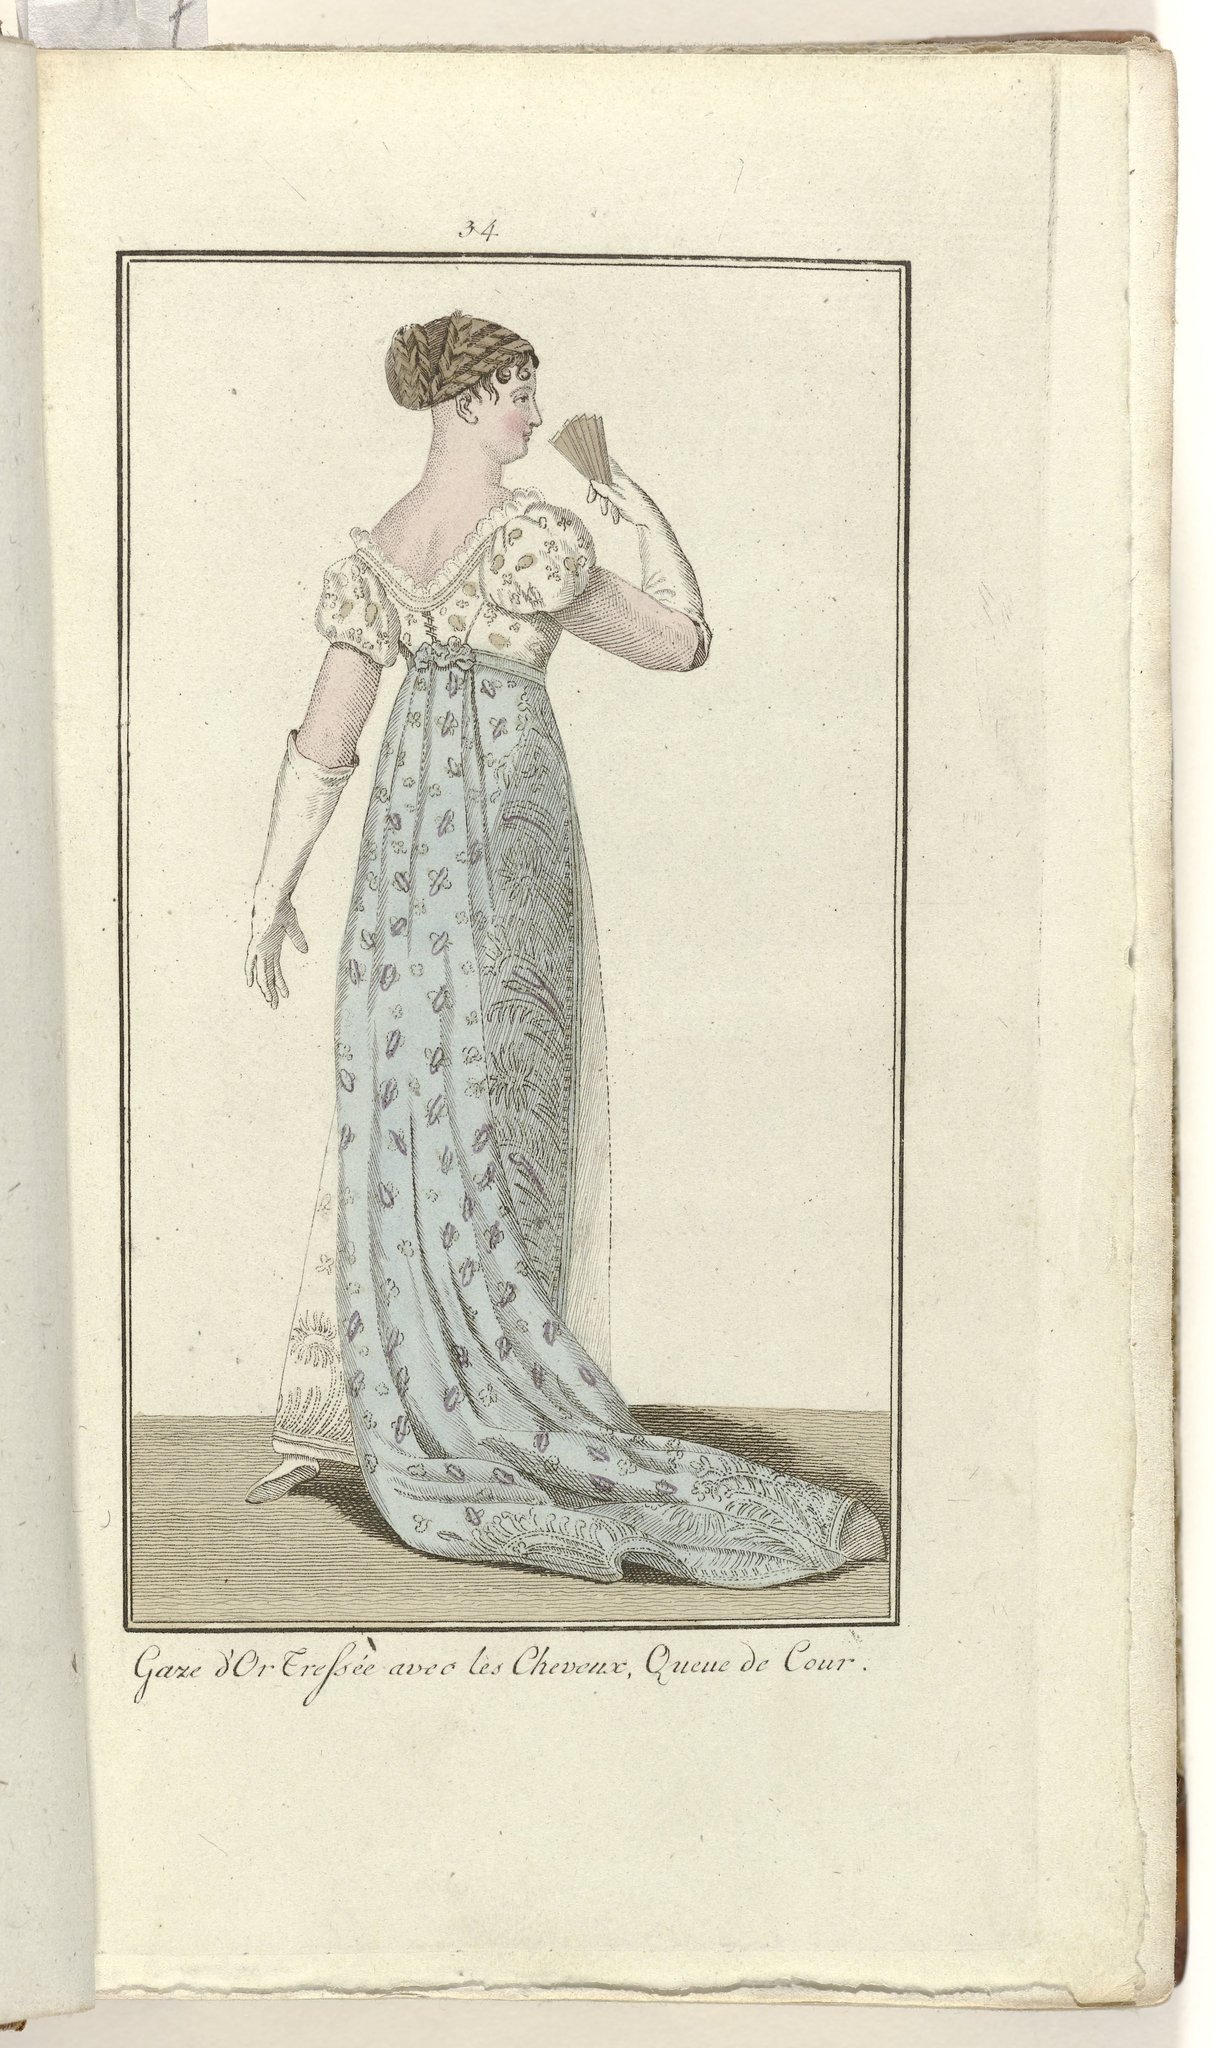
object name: magazine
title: Elegantia, of tijdschrift van mode, luxe en smaak voor dames, Januari 1808, No. 34: Gaze d'Or...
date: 1808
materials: paper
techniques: engraving, hand coloring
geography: amsterdam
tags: dress, gown: court gown or court dress (+ women's clothes), gloves, mittens (long gloves) (+ women's clothes), embroidery (ornamentation) (+ women's clothes), styles of hairdress - aa - ~ women, fashion plates, fan (+ women's clothes)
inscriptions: caption: ‘Gaze d'Or Tressée avec les Cheveux, Queue de Cour.’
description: Volgens de begeleidende tekst (p. 32): Kostbaar hofkostuum van mousseline met gouden borduursels. Blauw satijnen losse hofsleep met dito borduursels. 'Coëffure' van goudgaas door de haren gevlochten. Prent uit het modetijdschrift Elegantia, of tijdschrift van mode, luxe en smaak voor dames 1807-1814 (onderbroken door de periode 1811-1813).